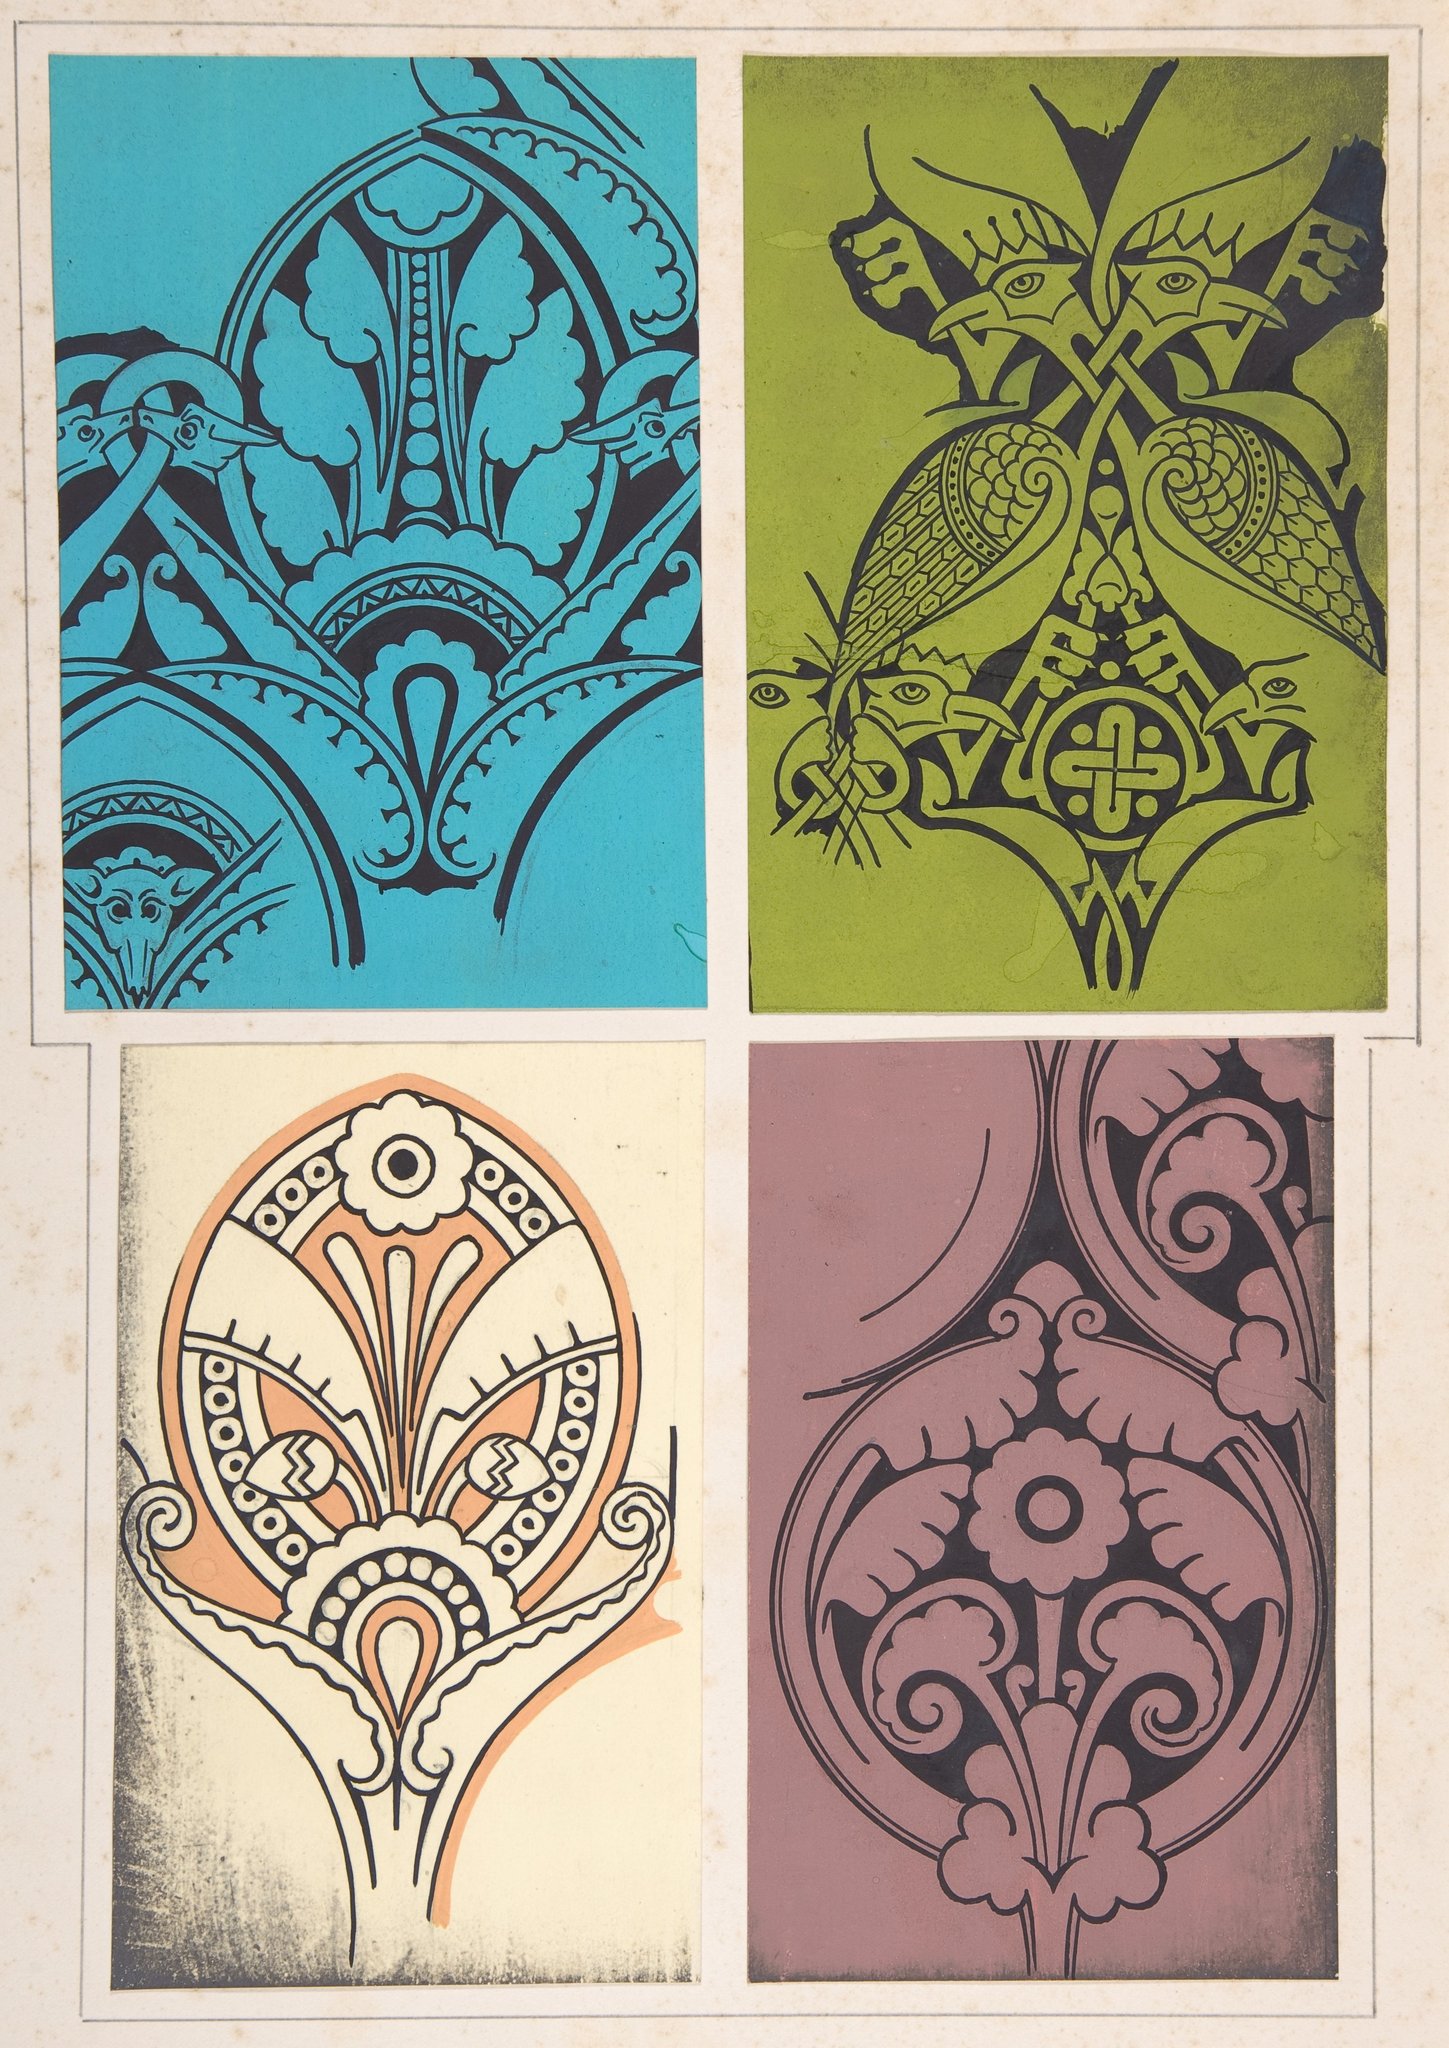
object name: drawing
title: Design drawing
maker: christopher dresser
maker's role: designer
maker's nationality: british, scottish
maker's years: 1834-1904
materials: gouache, graphite, ink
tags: birds,ornament